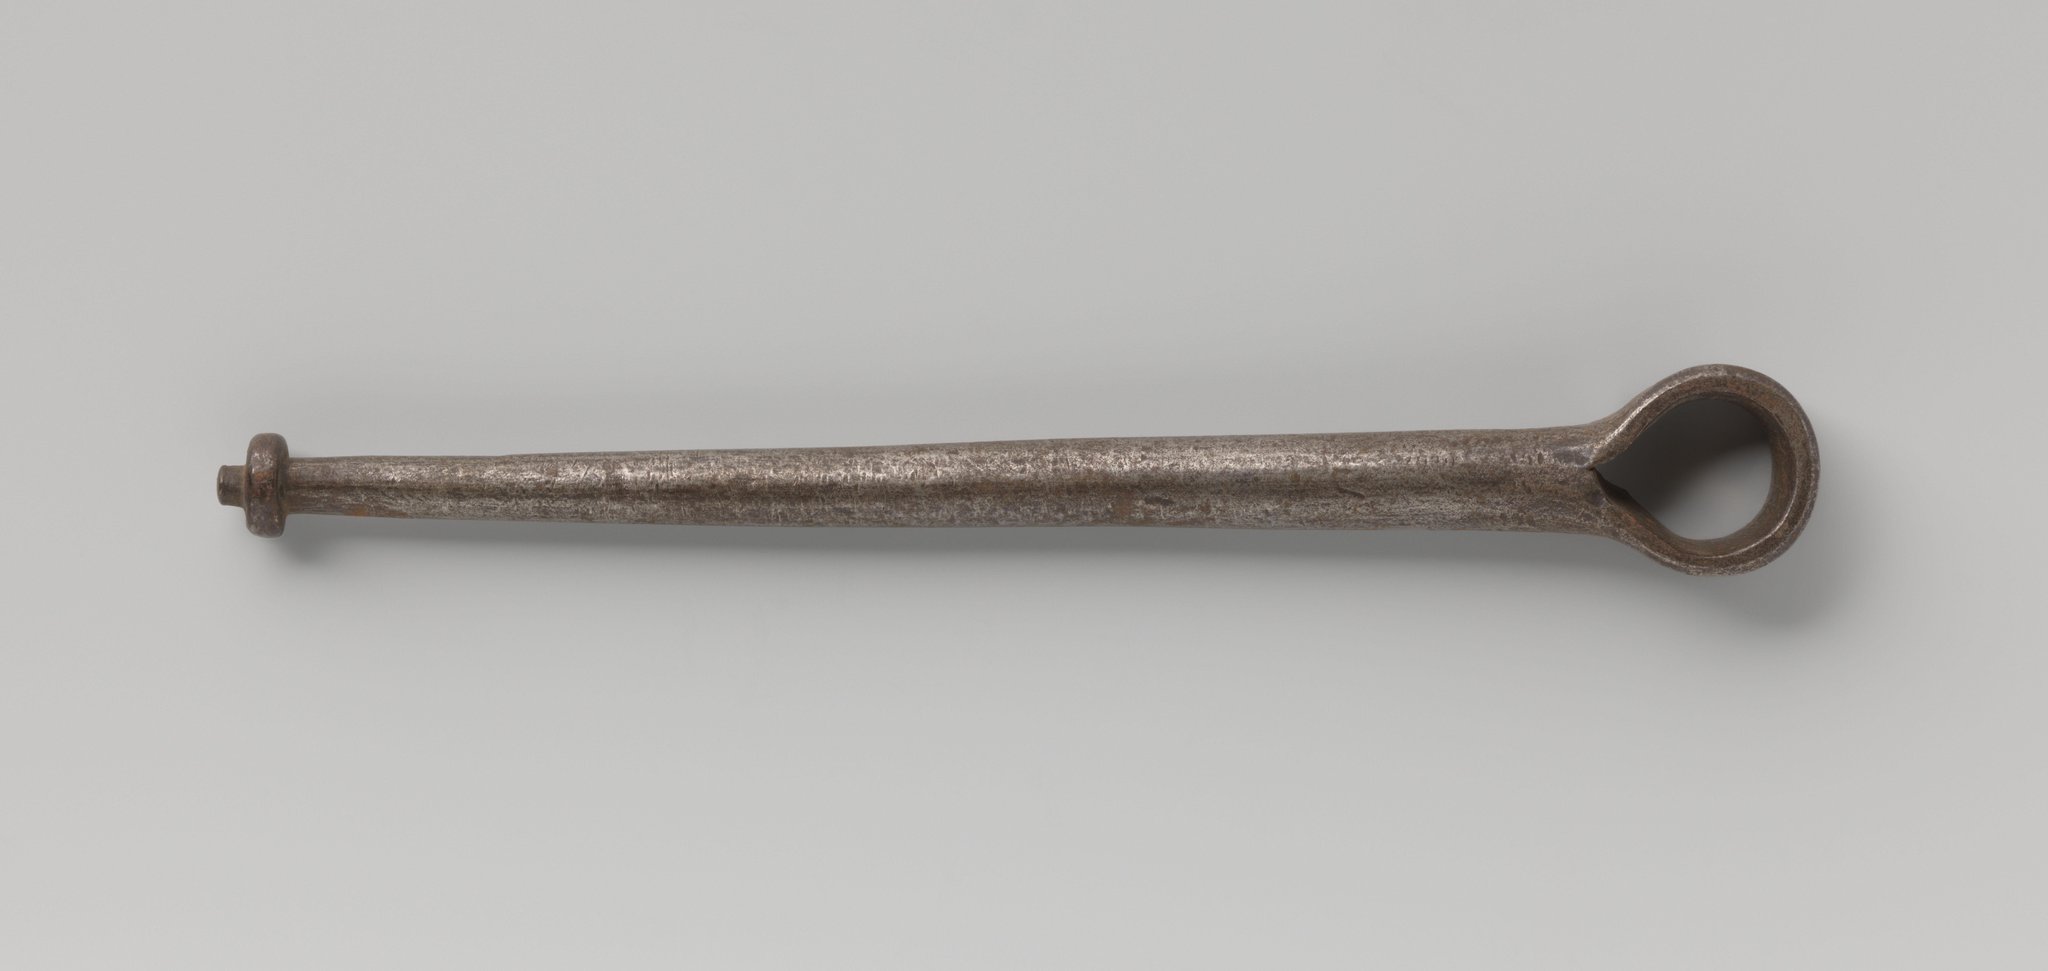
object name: key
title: Pin van archiefkist van ijzer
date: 1700-1800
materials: iron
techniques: forging